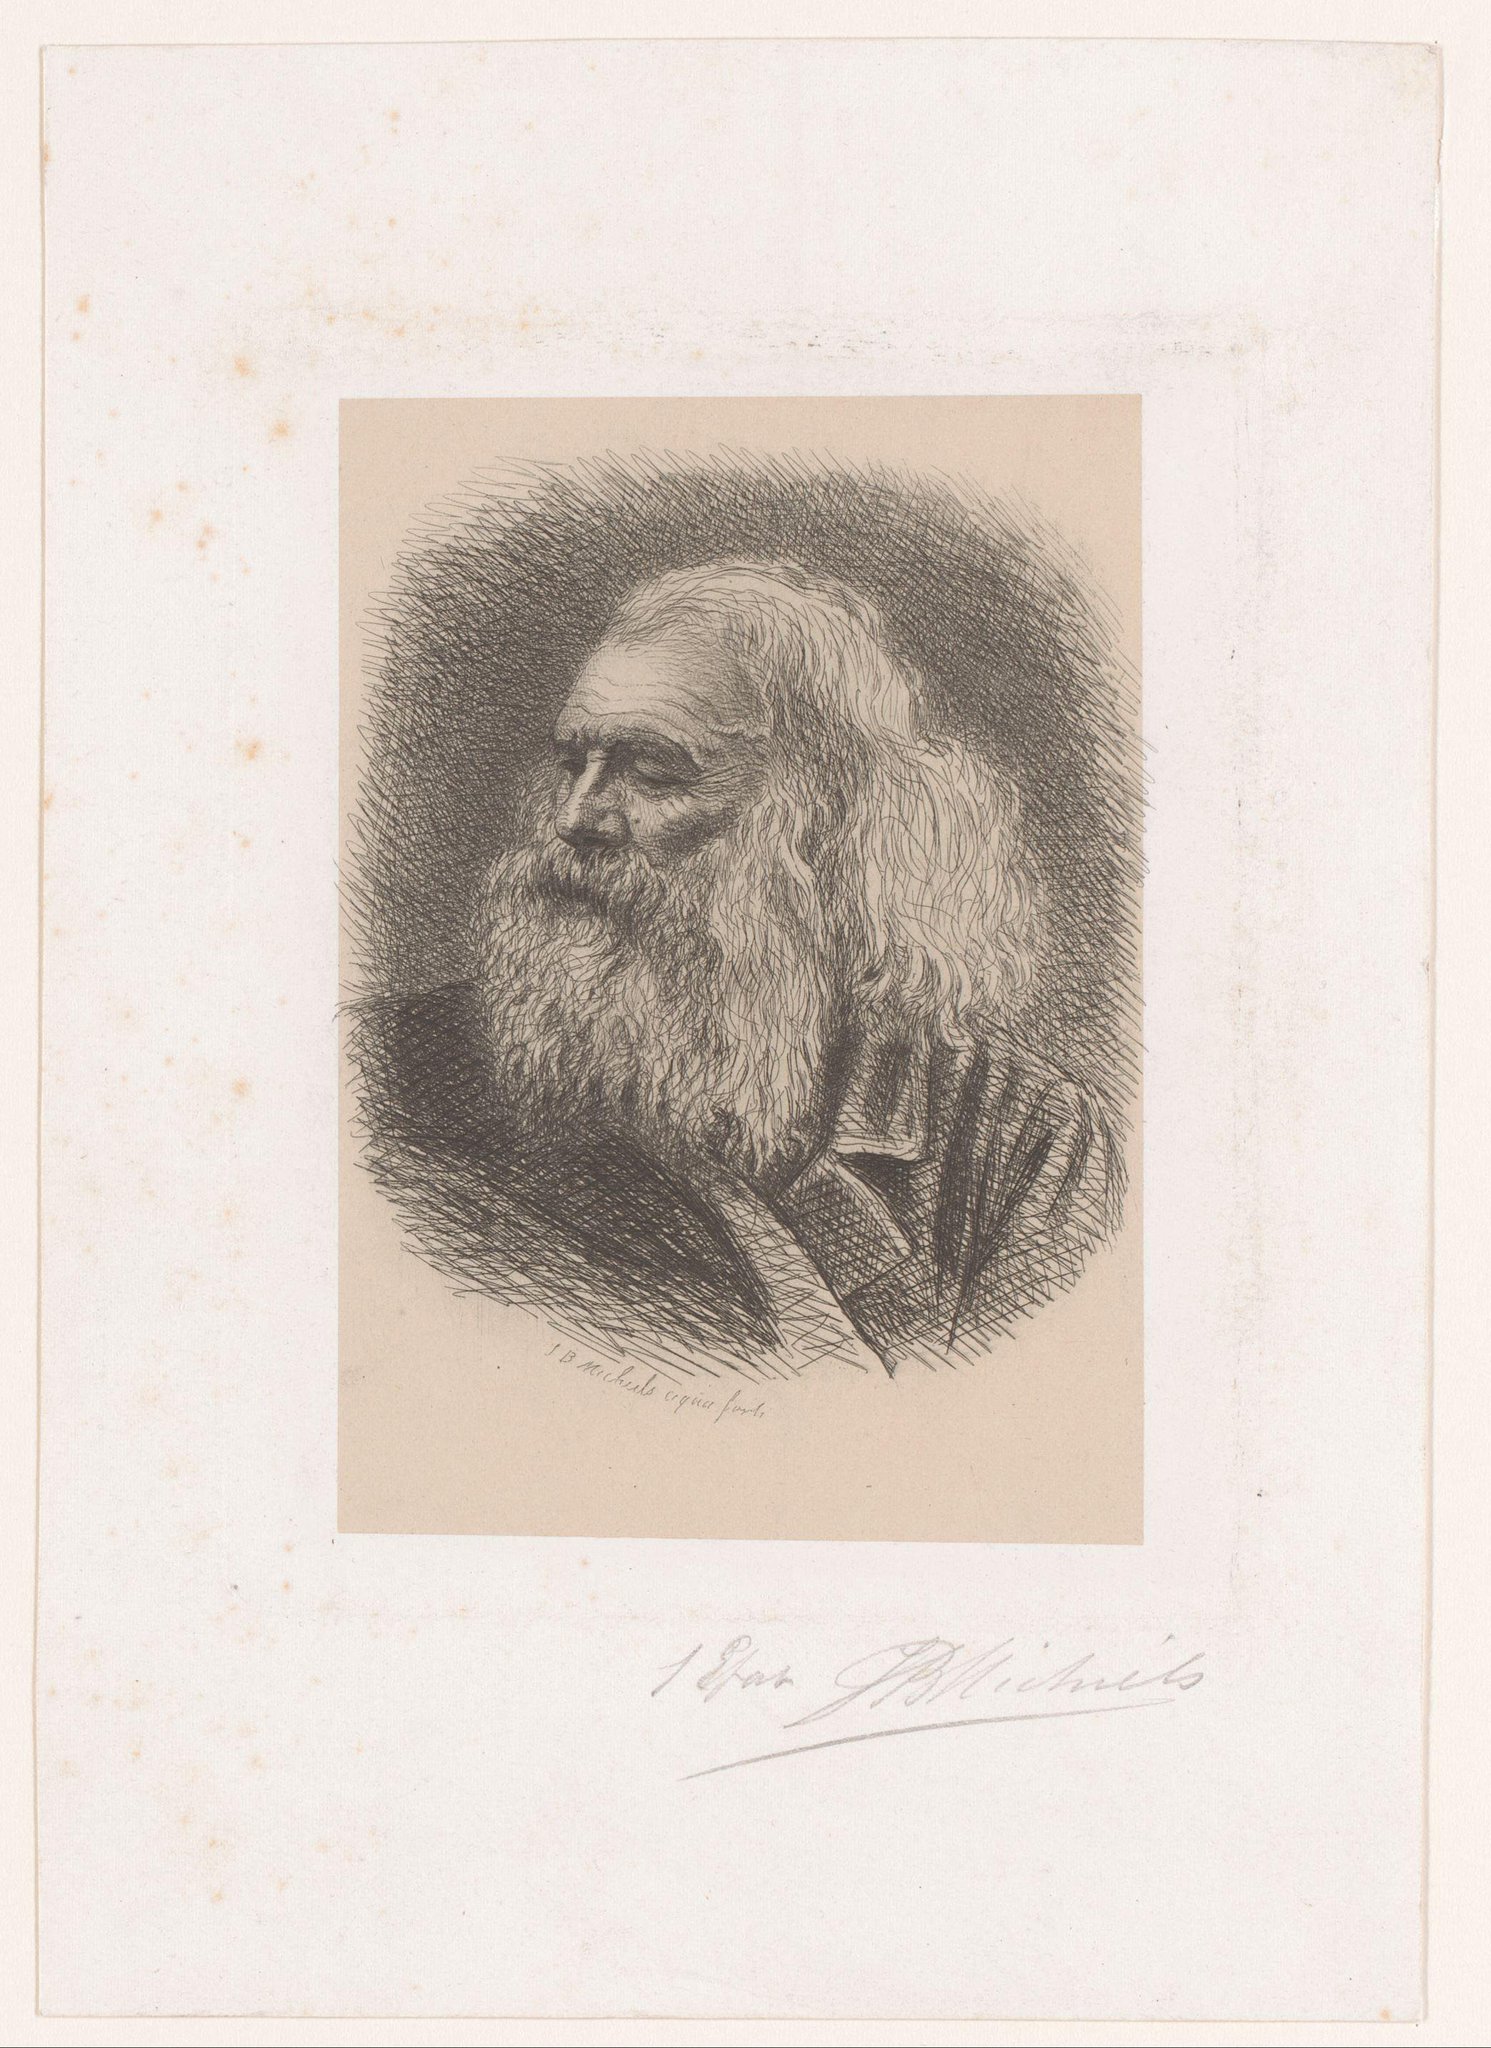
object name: print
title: Hoofd van een oude man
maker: jean baptiste pierre michiels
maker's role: print maker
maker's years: 1821-1890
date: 1831-1890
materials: paper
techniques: etching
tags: old man, beard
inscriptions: inscription: ‘1 Etat’, collector's mark: Lugt 2228